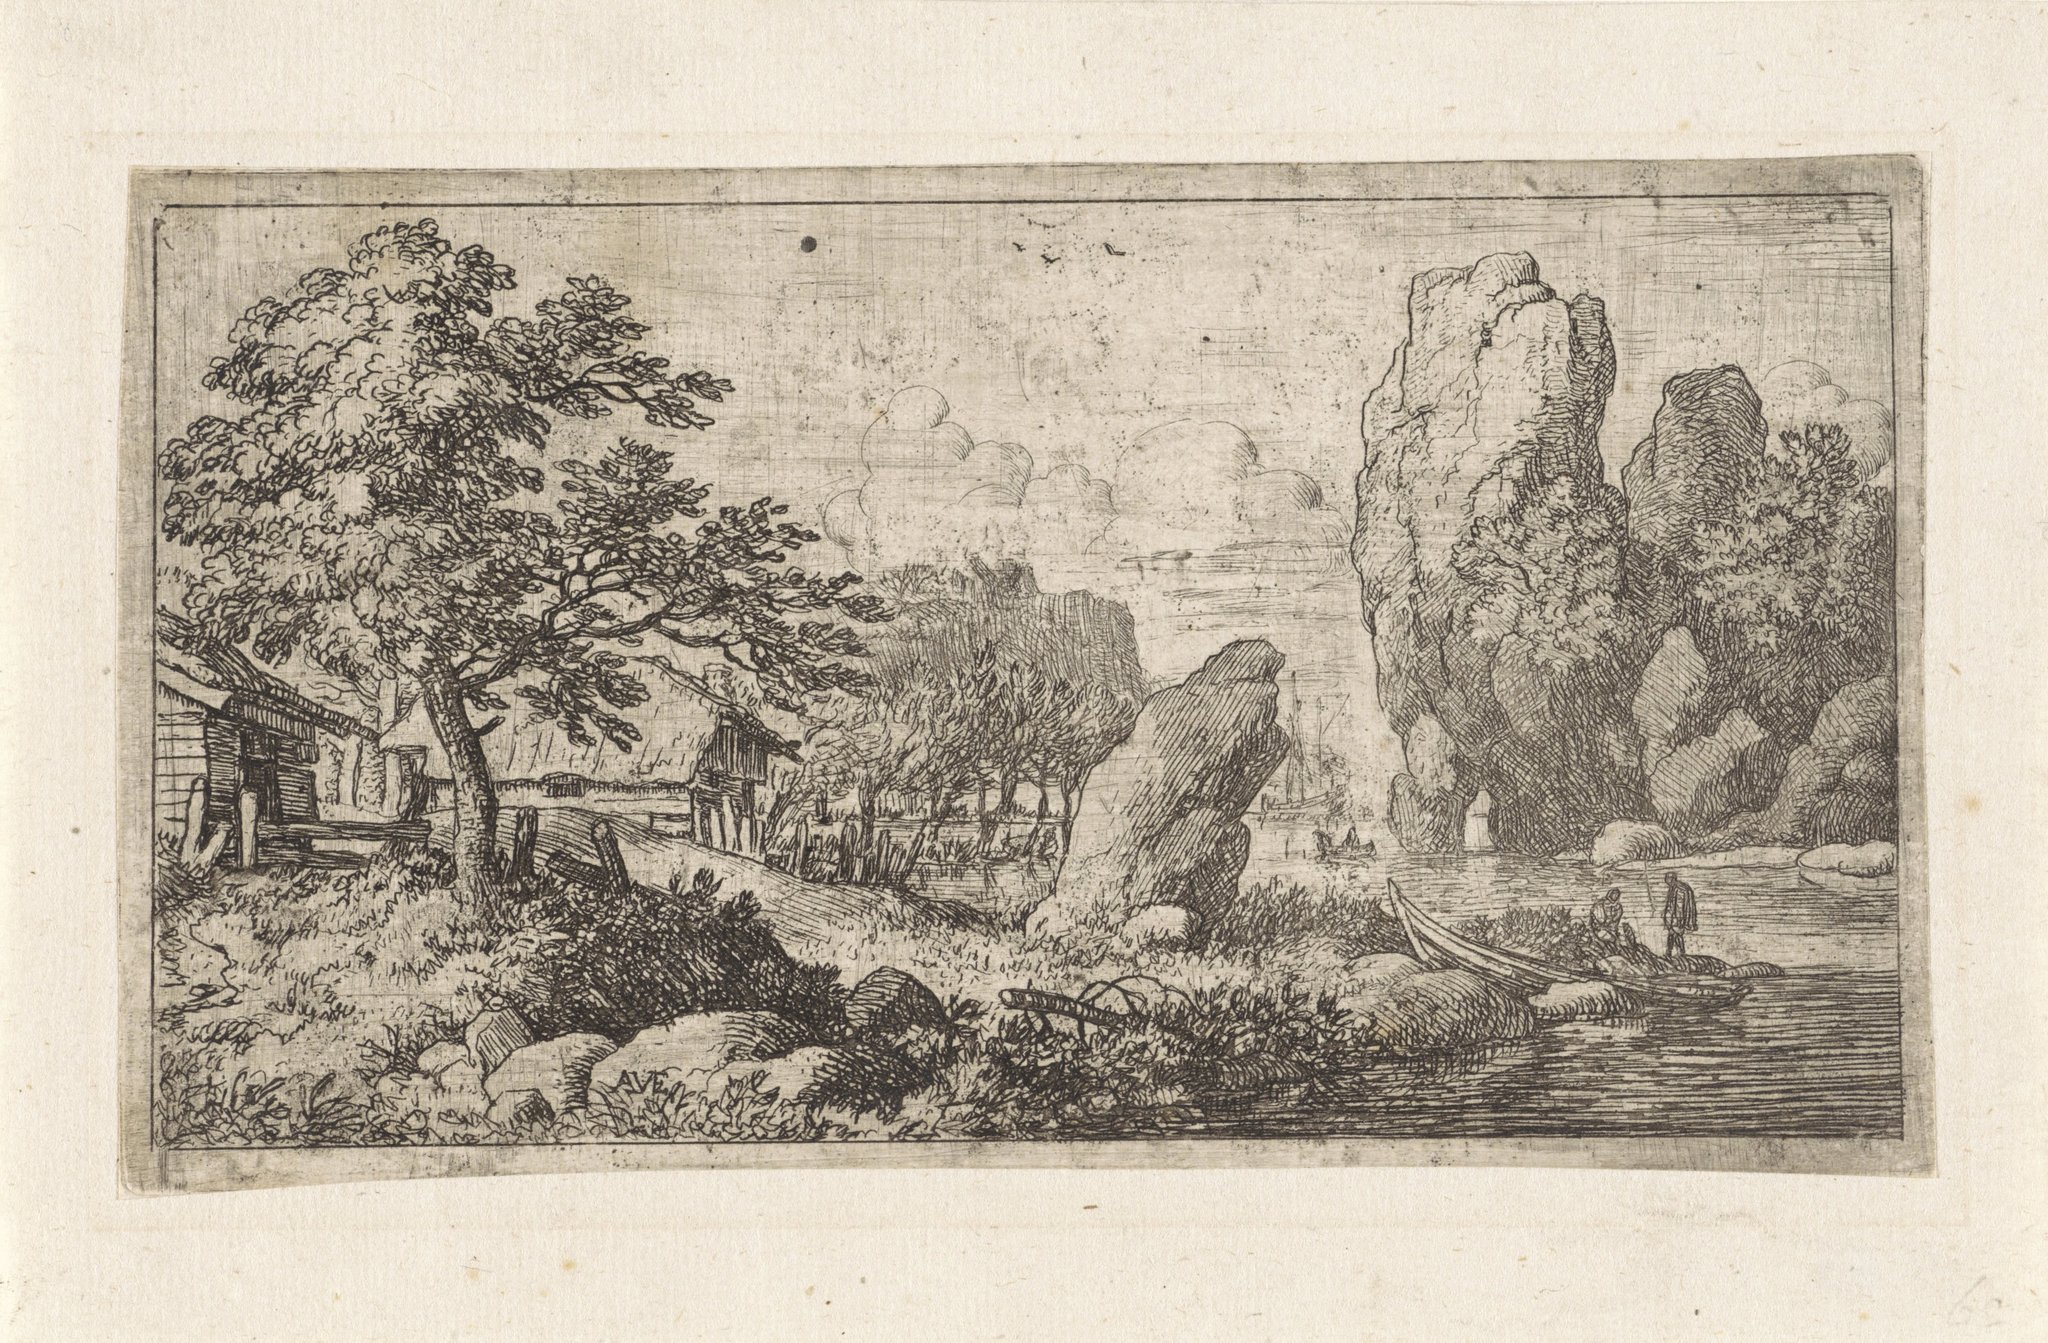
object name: print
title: Landschap met rots aan het water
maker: allaert van everdingen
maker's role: draughtsman, painter, print maker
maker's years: 1621-1675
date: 1631-1675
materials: paper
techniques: etching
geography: netherlands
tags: river (+ landscape with figures, staffage)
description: Gezicht op een boom en enkele huizen langs een rivier. Op de oever een roeiboot, twee personen en hoge rotsen.